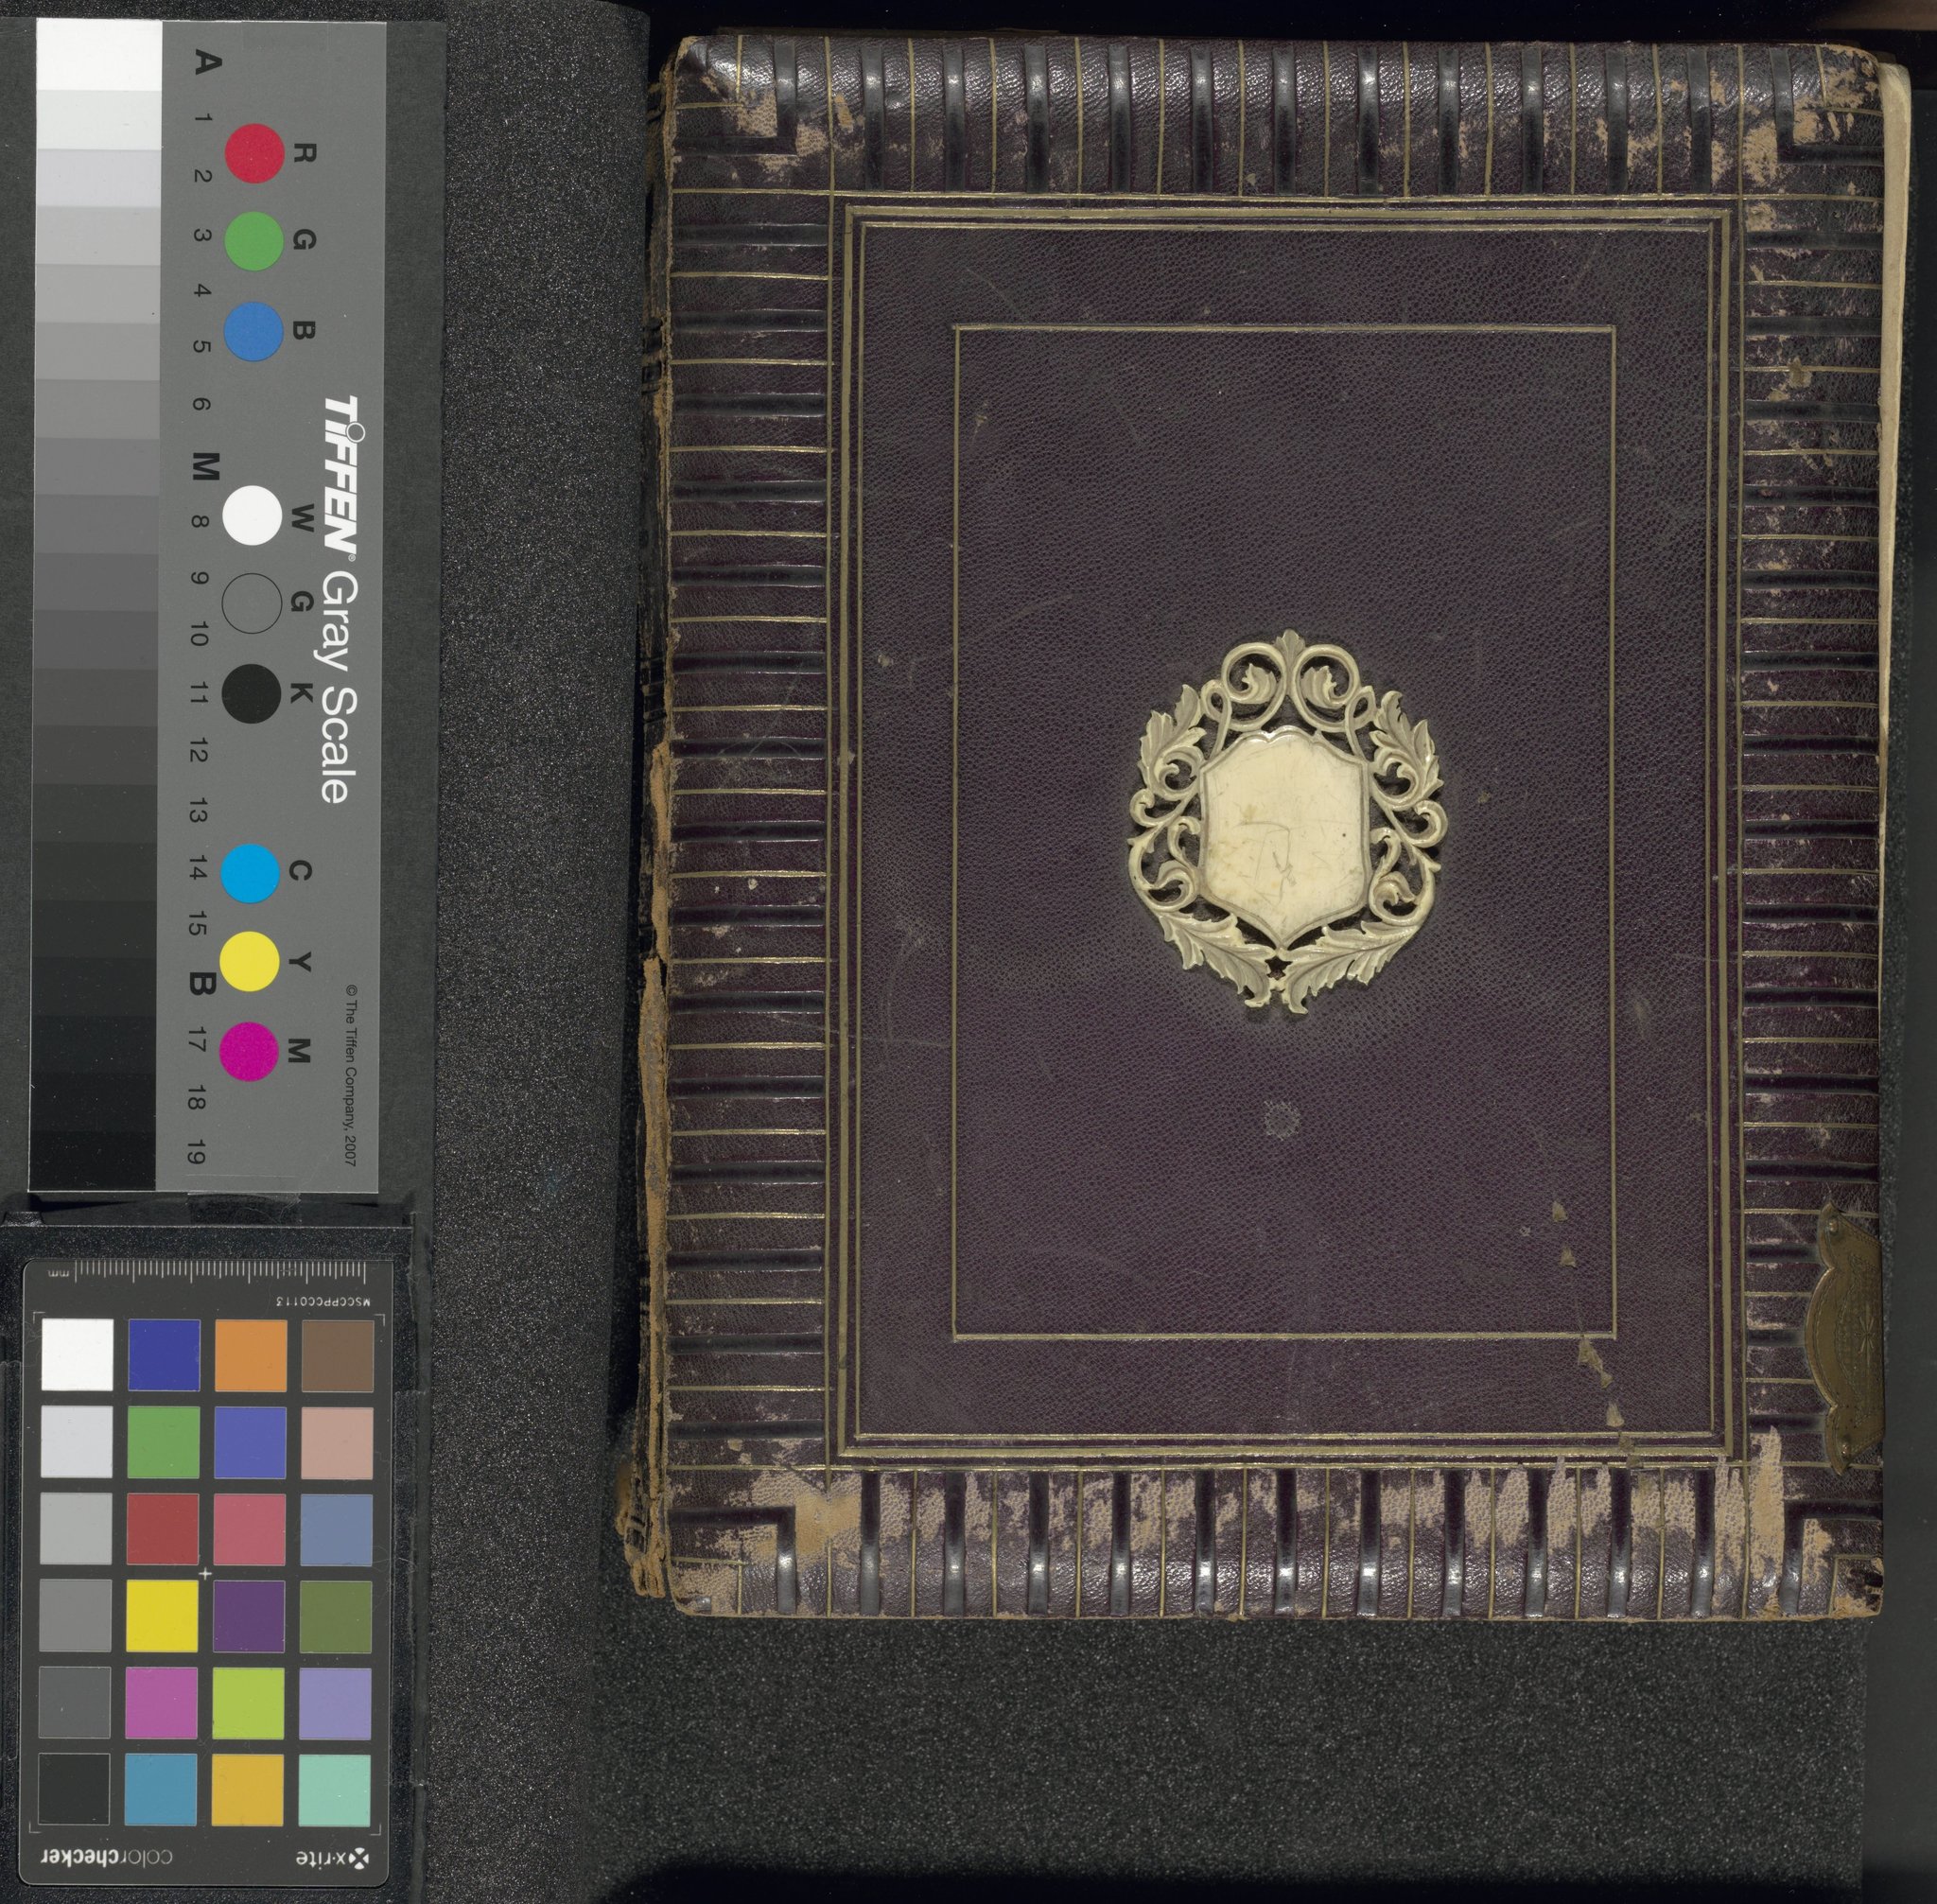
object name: slip in album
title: Photographie-Album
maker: Anonymous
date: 1860-1890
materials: cardboard, copper, ivory, leather, metal, paper, photographic support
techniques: albumen print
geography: netherlands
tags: studio requisites ~ photographer, historical persons, family, relationship, descent, netherlands, dutch east indies, the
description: Fotoalbum in bruin leren omslag, aan de randen versierd met lijnen in gouddruk. Op de voorzijde een geornamenteerd wapenschild van ivoor en een metalen restant van een slot. Op de achterzijde drie ivoren knopjes gevat in metalen ringetjes die het album moeten ondersteunen. Eén knopje ontbreekt. De binnenkant van de voorzijde bevat in gouddruk de tekst 'Photographie-Album' binnen een geornamenteerd kader. Het album telt 25 kartonnen bladen goud op snee met in gouddruk omkaderde passe-partouts. Deze bevatten voor het merendeel cartes-de-visite en enkele kabinetfoto's en foto's. Twee foto's zitten los in mapjes. De rug van het album is gescheurd, waardoor de bladen en de voor- en achterzijde los liggen. Het betreft foto's uit het familiealbum van H.W.F. Ligtenberg en L. M. Swart, opgenomen in Nederland en Nederlands-Indië. H.W.F. Ligtenberg was notaris te Pasoeroewan, en werd op 30 december 1870 benoemd tot notaris in Soerabaja.